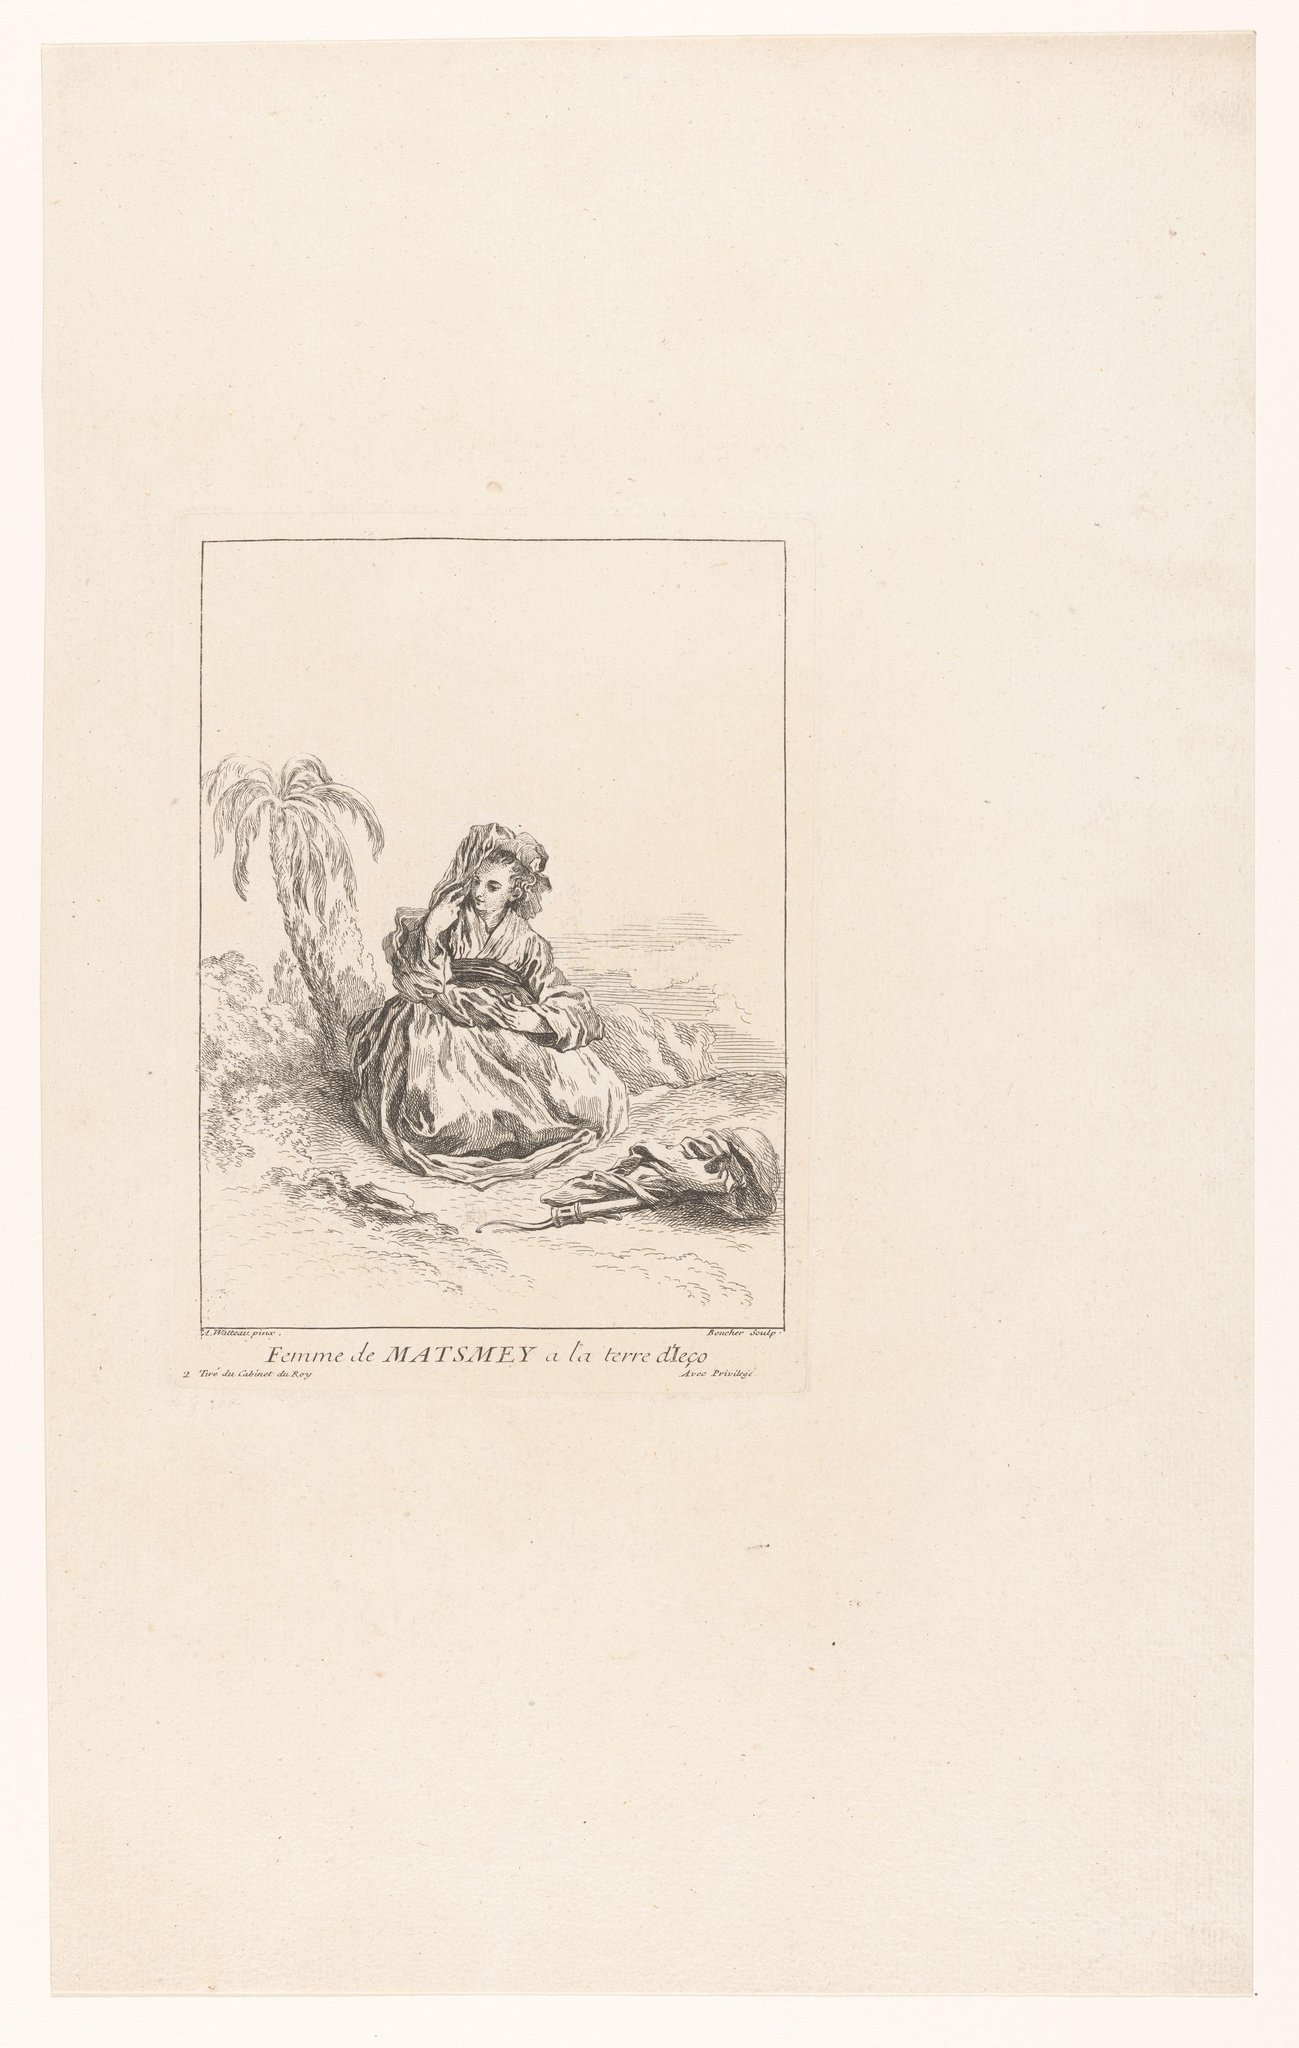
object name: print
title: L'Oeuvre d'Antoine Watteau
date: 1731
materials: paper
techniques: etching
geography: paris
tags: chinese, sitting on the ground - aa - female human figure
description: Maakt deel uit van een serie van 271 platen, inclusief twee titelprenten, naar schilderijen door Watteau en verzameld door Jean de Jullienne. Sommige platen werden reeds tijdens Watteau's leven vervaardigd en de rest kwam pas na zijn dood tot stand. In 1734 werd het eind van de serie aangekondigd. Deze plaat betreft nr. 237 van de serie. Maakt eveneens deel uit van een subgroep van twaalf prenten, getiteld 'Diverses Figures Chinoises et Tartares Peintes par Watteau (...)'.